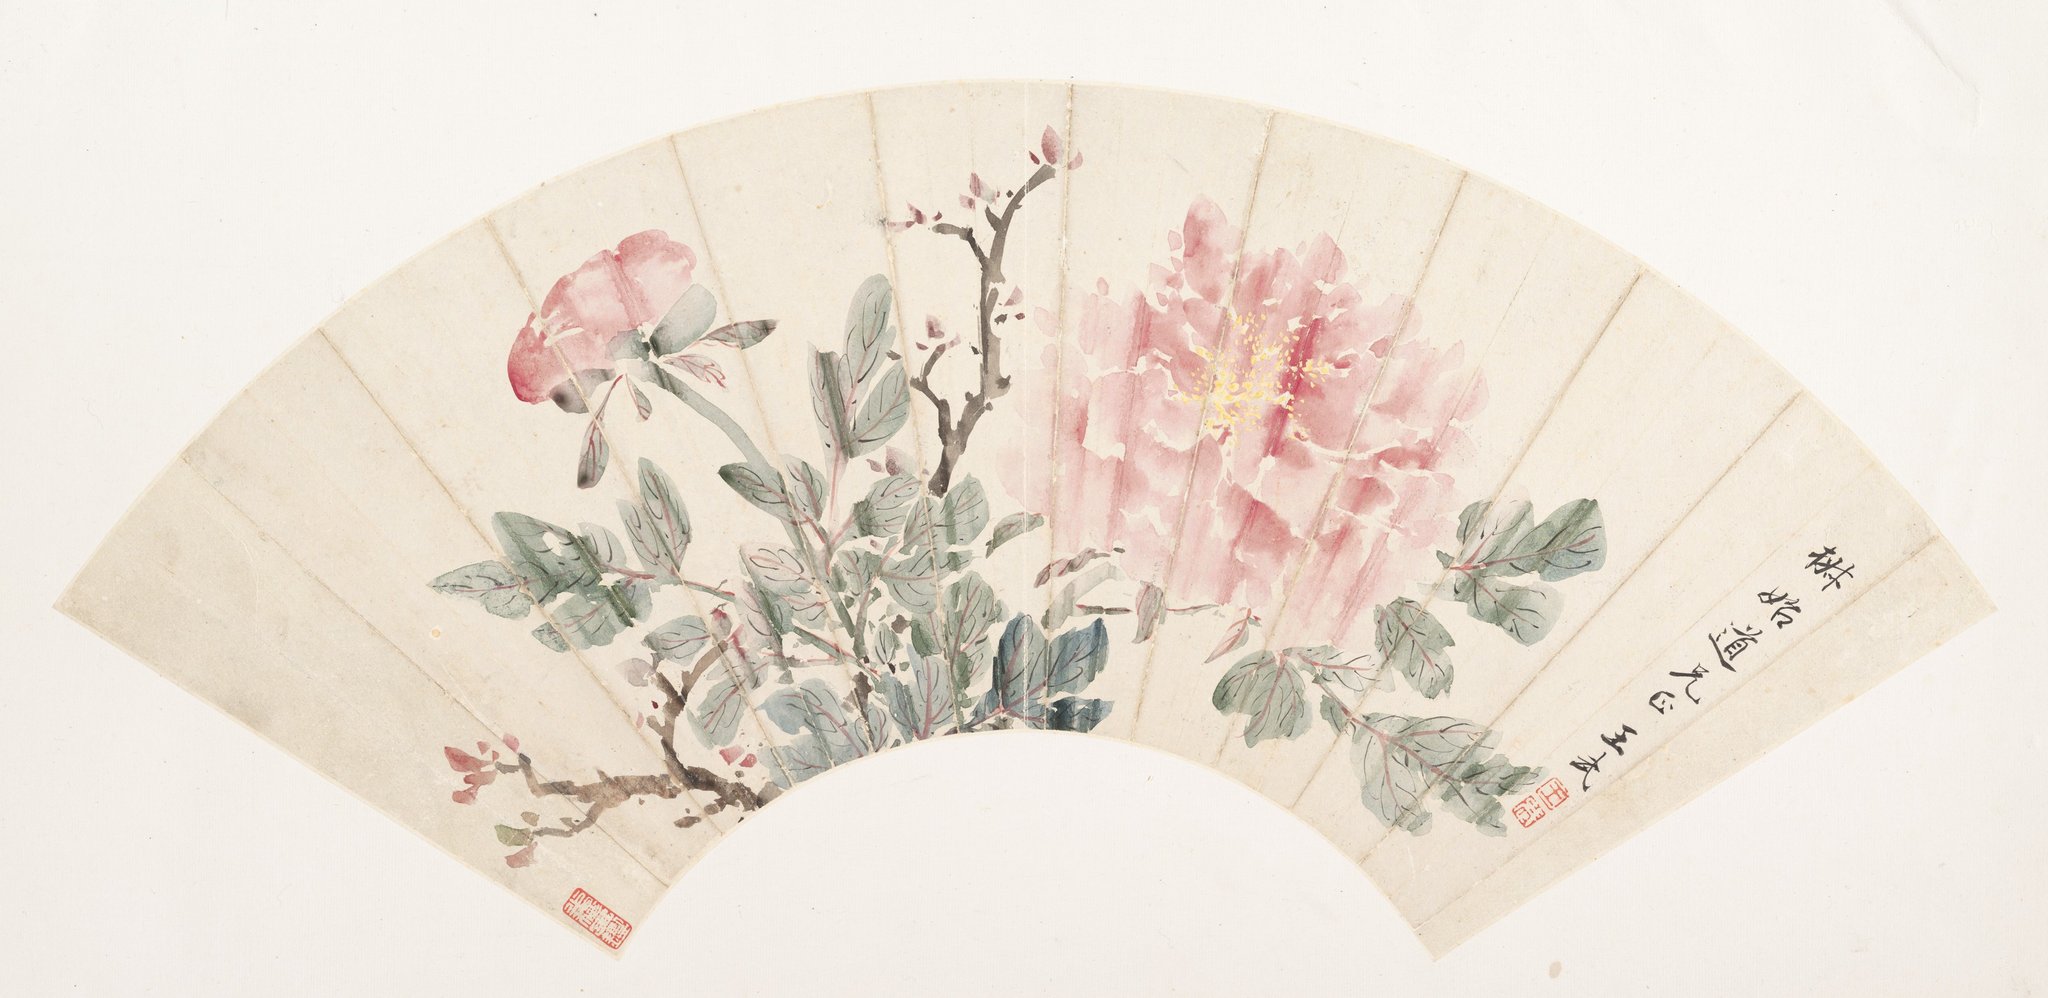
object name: folding fan mounted a an album leaf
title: Peony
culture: chinese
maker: wang wu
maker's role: artist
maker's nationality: chinese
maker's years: 1632-1690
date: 1667-1700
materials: ink, paper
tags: peonies